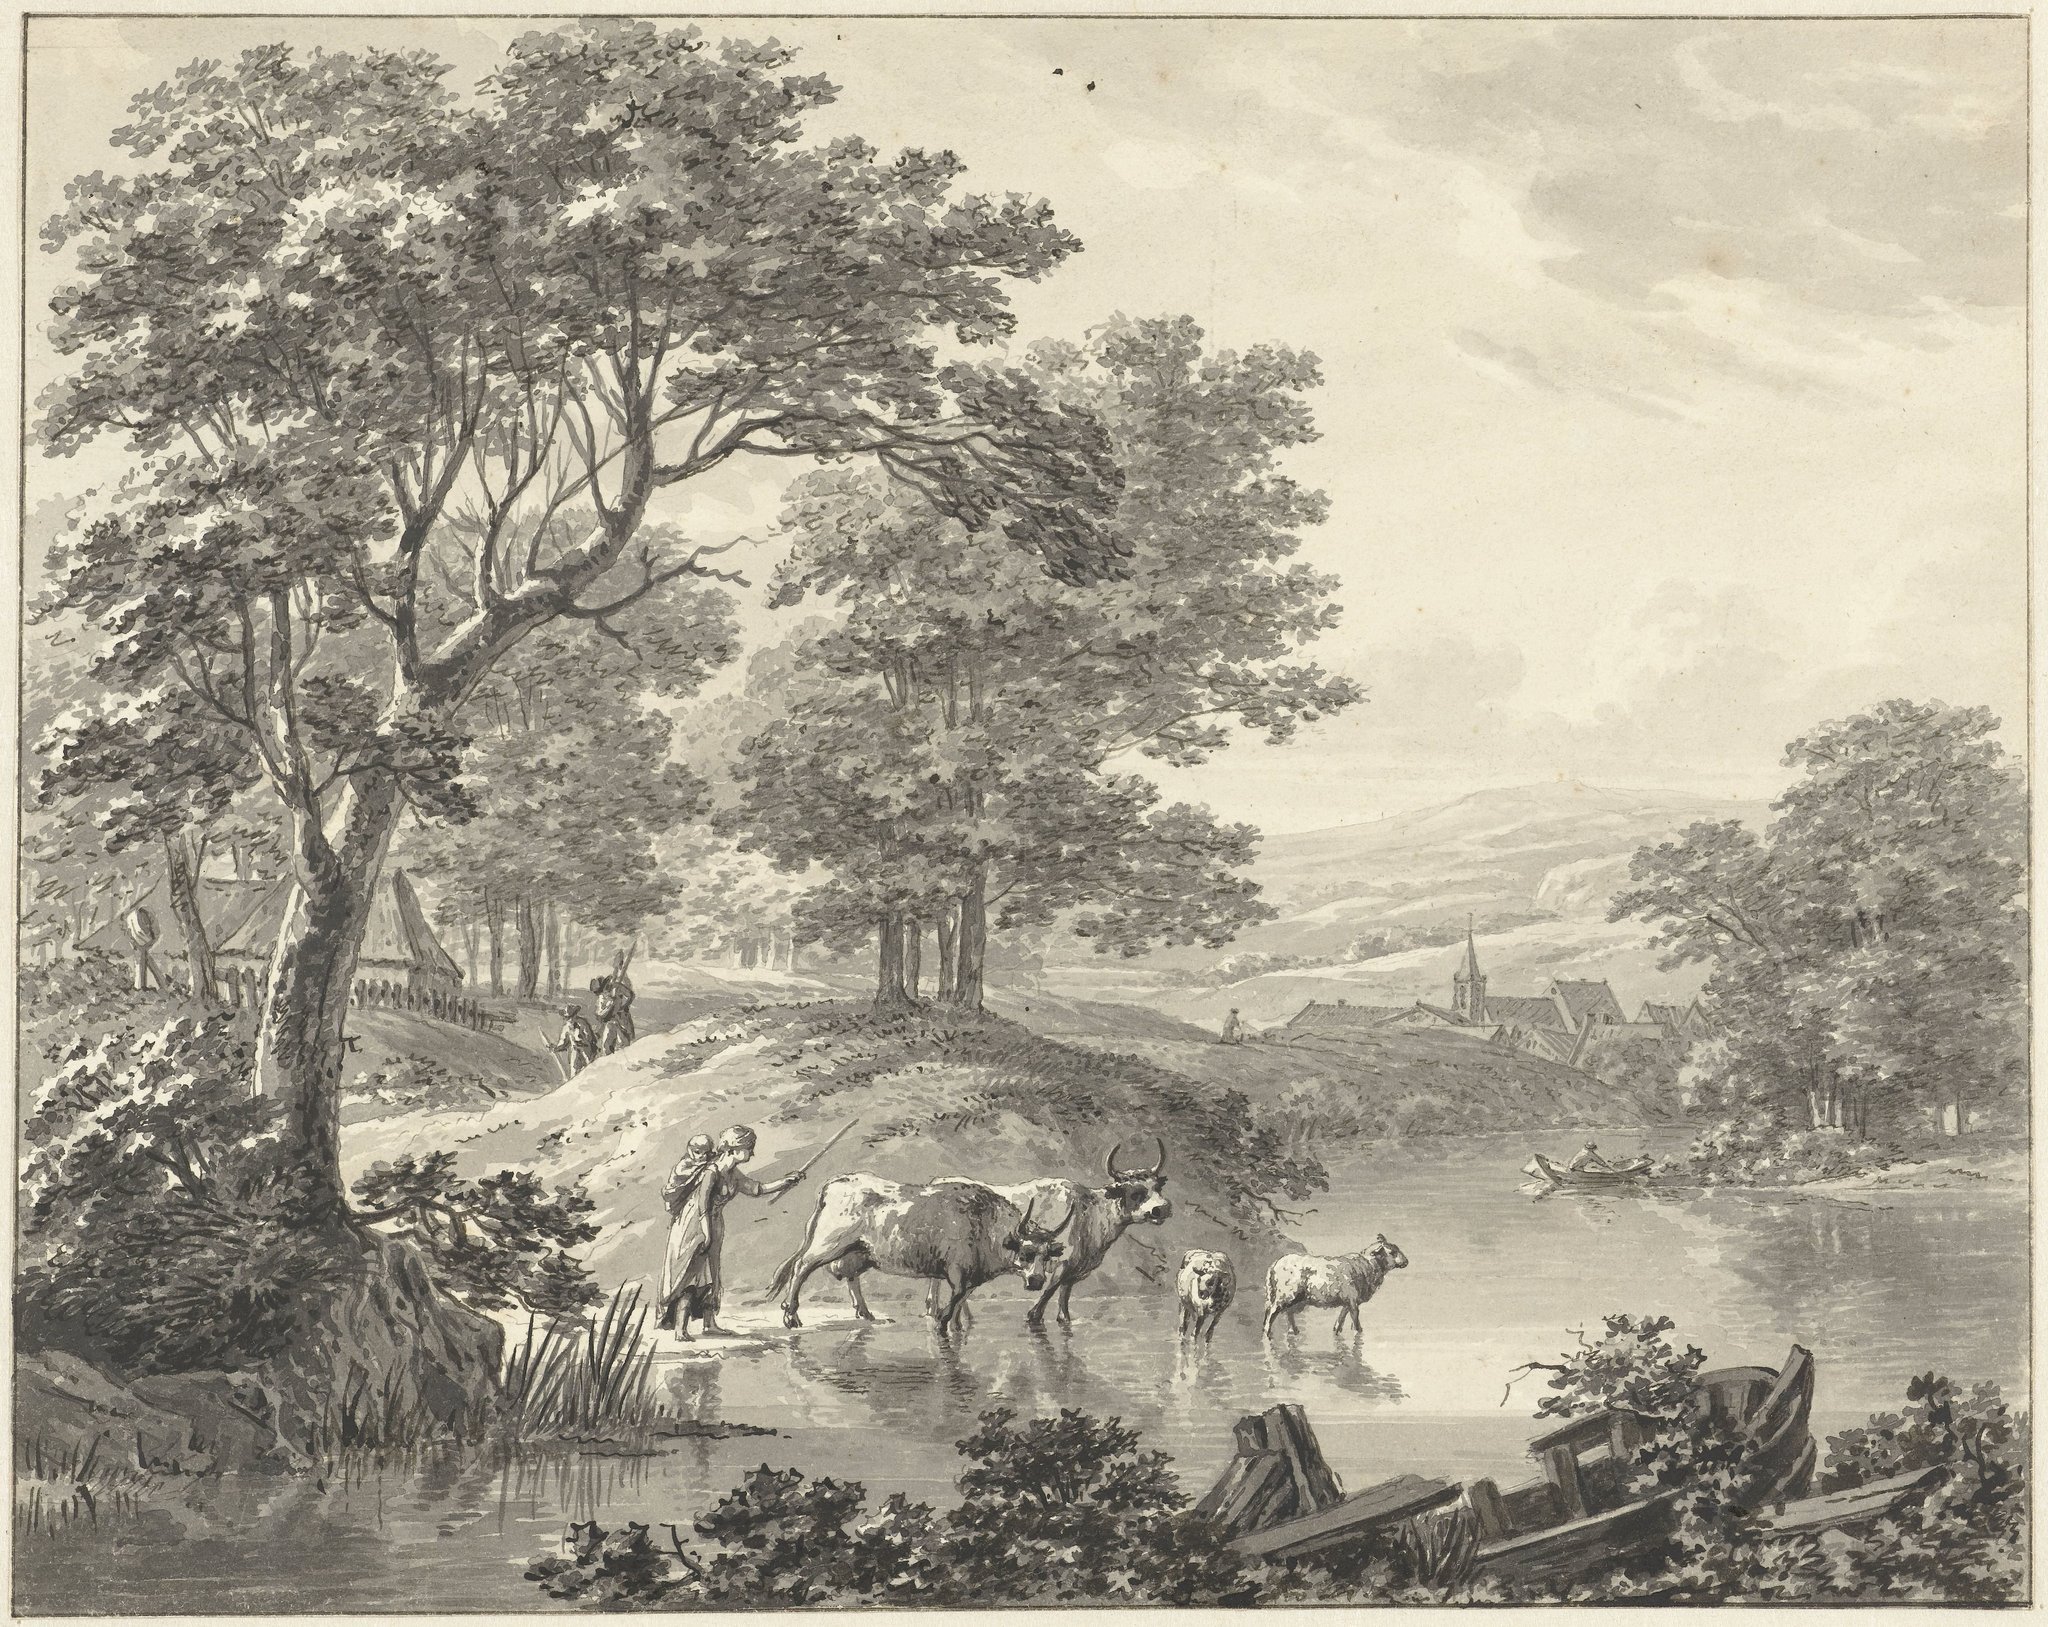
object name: drawing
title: Landschap met vee bij voorde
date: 1754-1820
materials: ink, paper, pencil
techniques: brush, pen